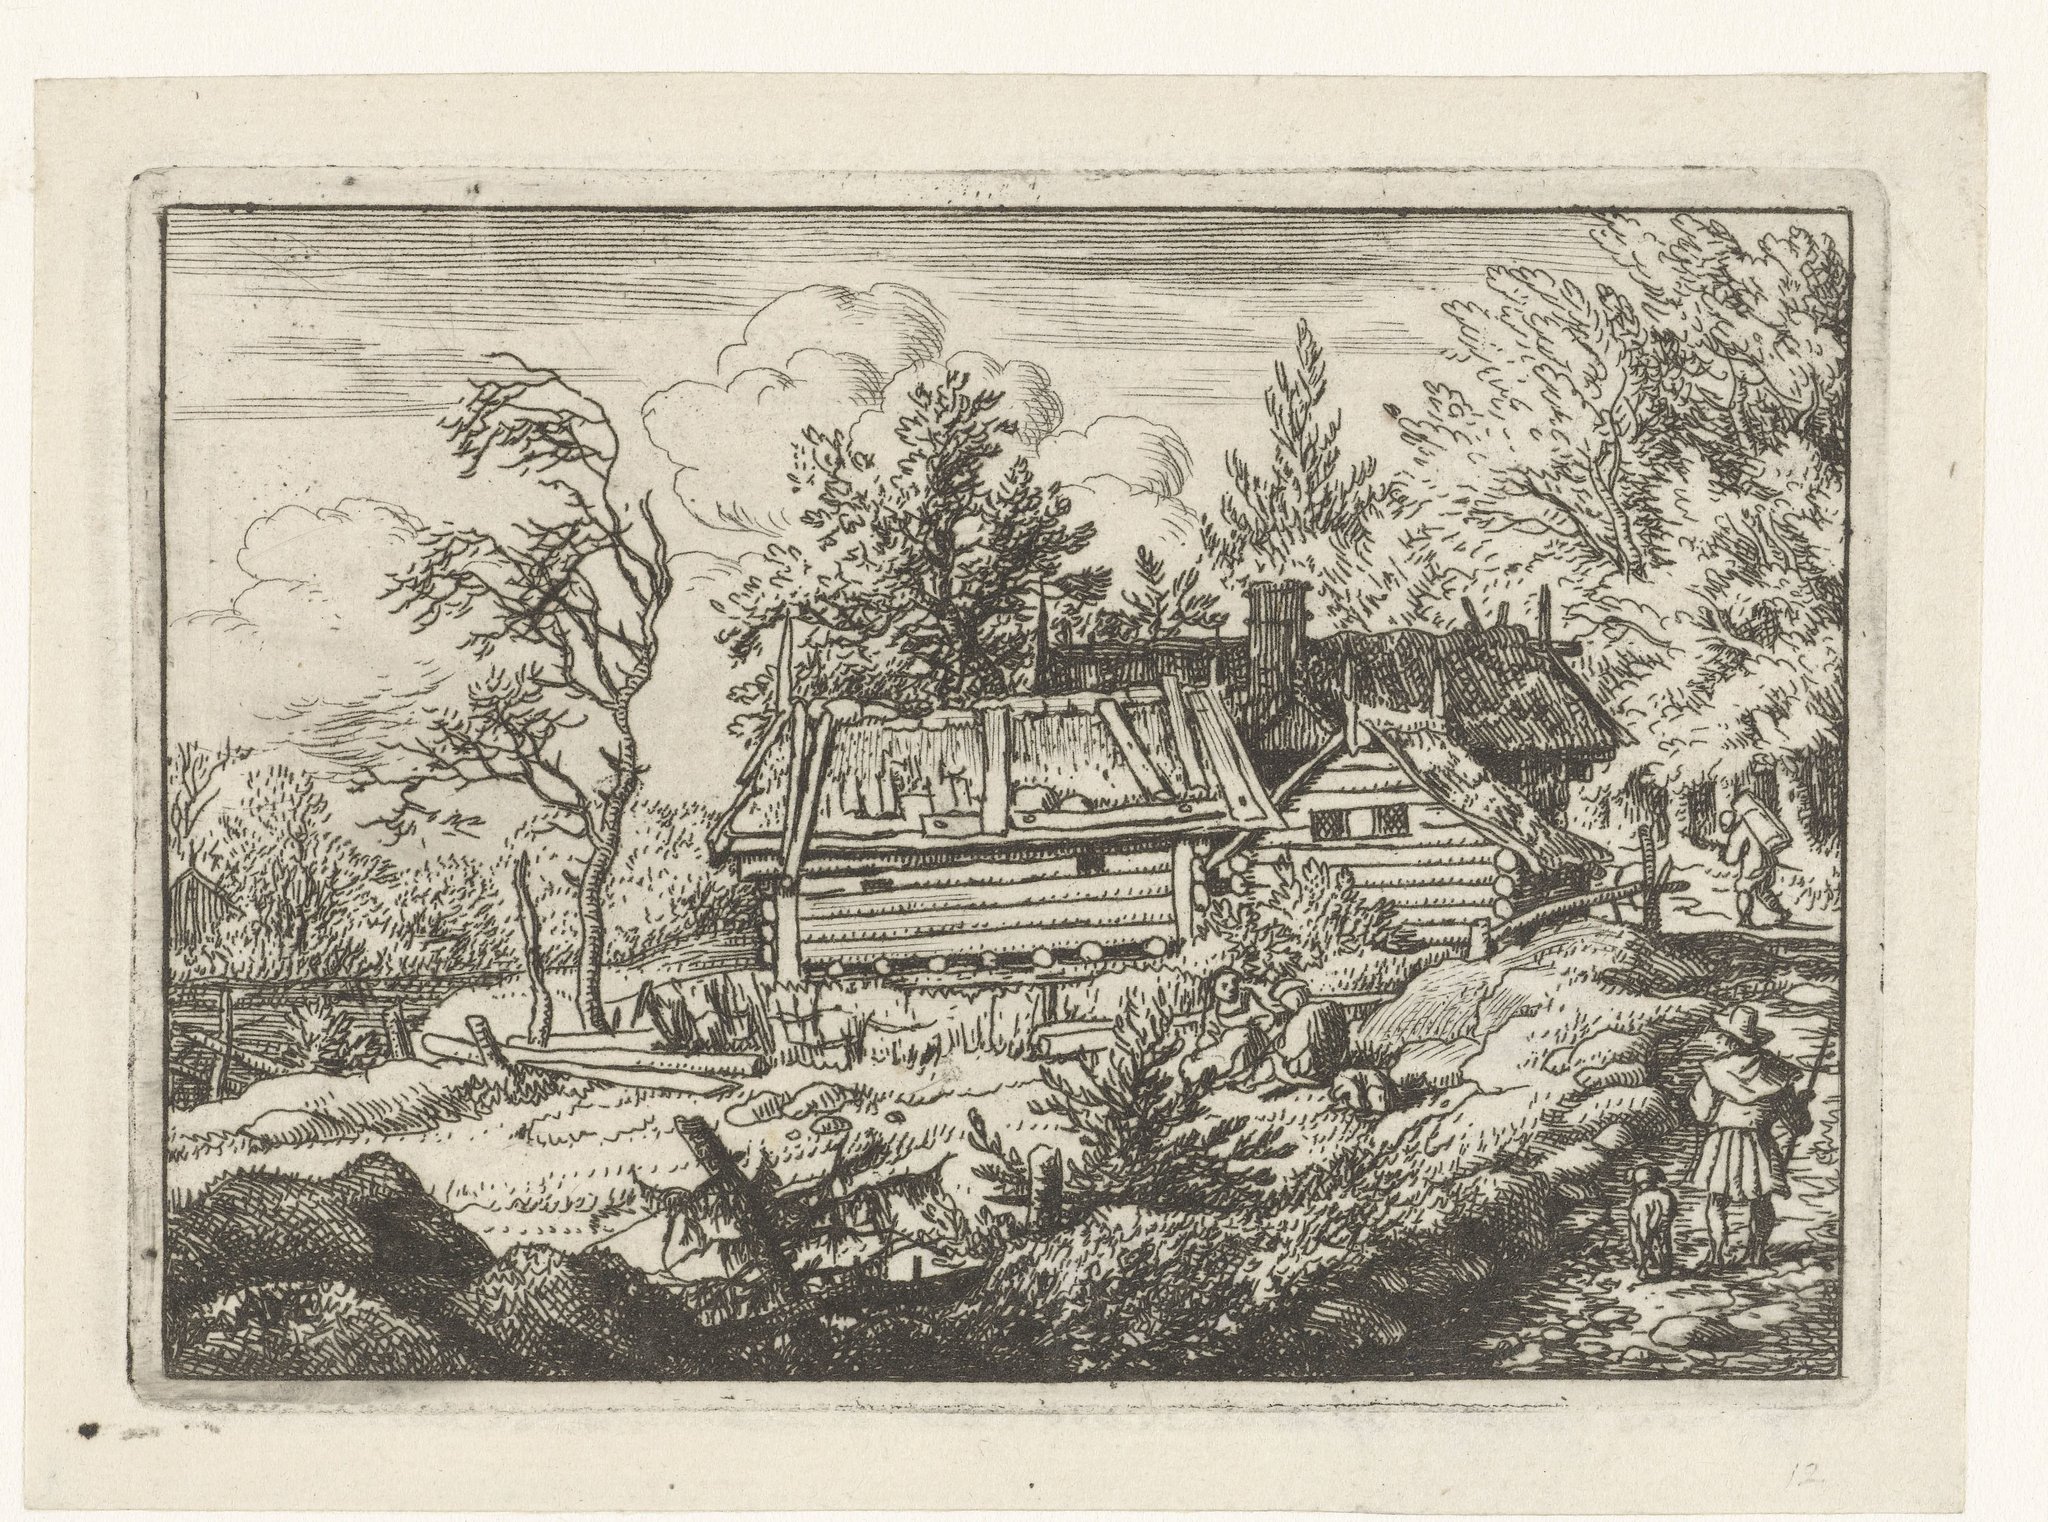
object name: print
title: Gehucht met wandelaar en hond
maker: allaert van everdingen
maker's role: draughtsman, painter, print maker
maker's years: 1621-1675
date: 1631-1675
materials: paper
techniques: etching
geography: netherlands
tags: farm or solitary house in landscape (+ city(-scape) with figures, staffage)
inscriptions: collector's mark: Lugt 2228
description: Landschap met drie houten gebouwen. Op het pad op de voorgrond een wandelaar met een hond. In het veld naast het pad twee zittende figuren.